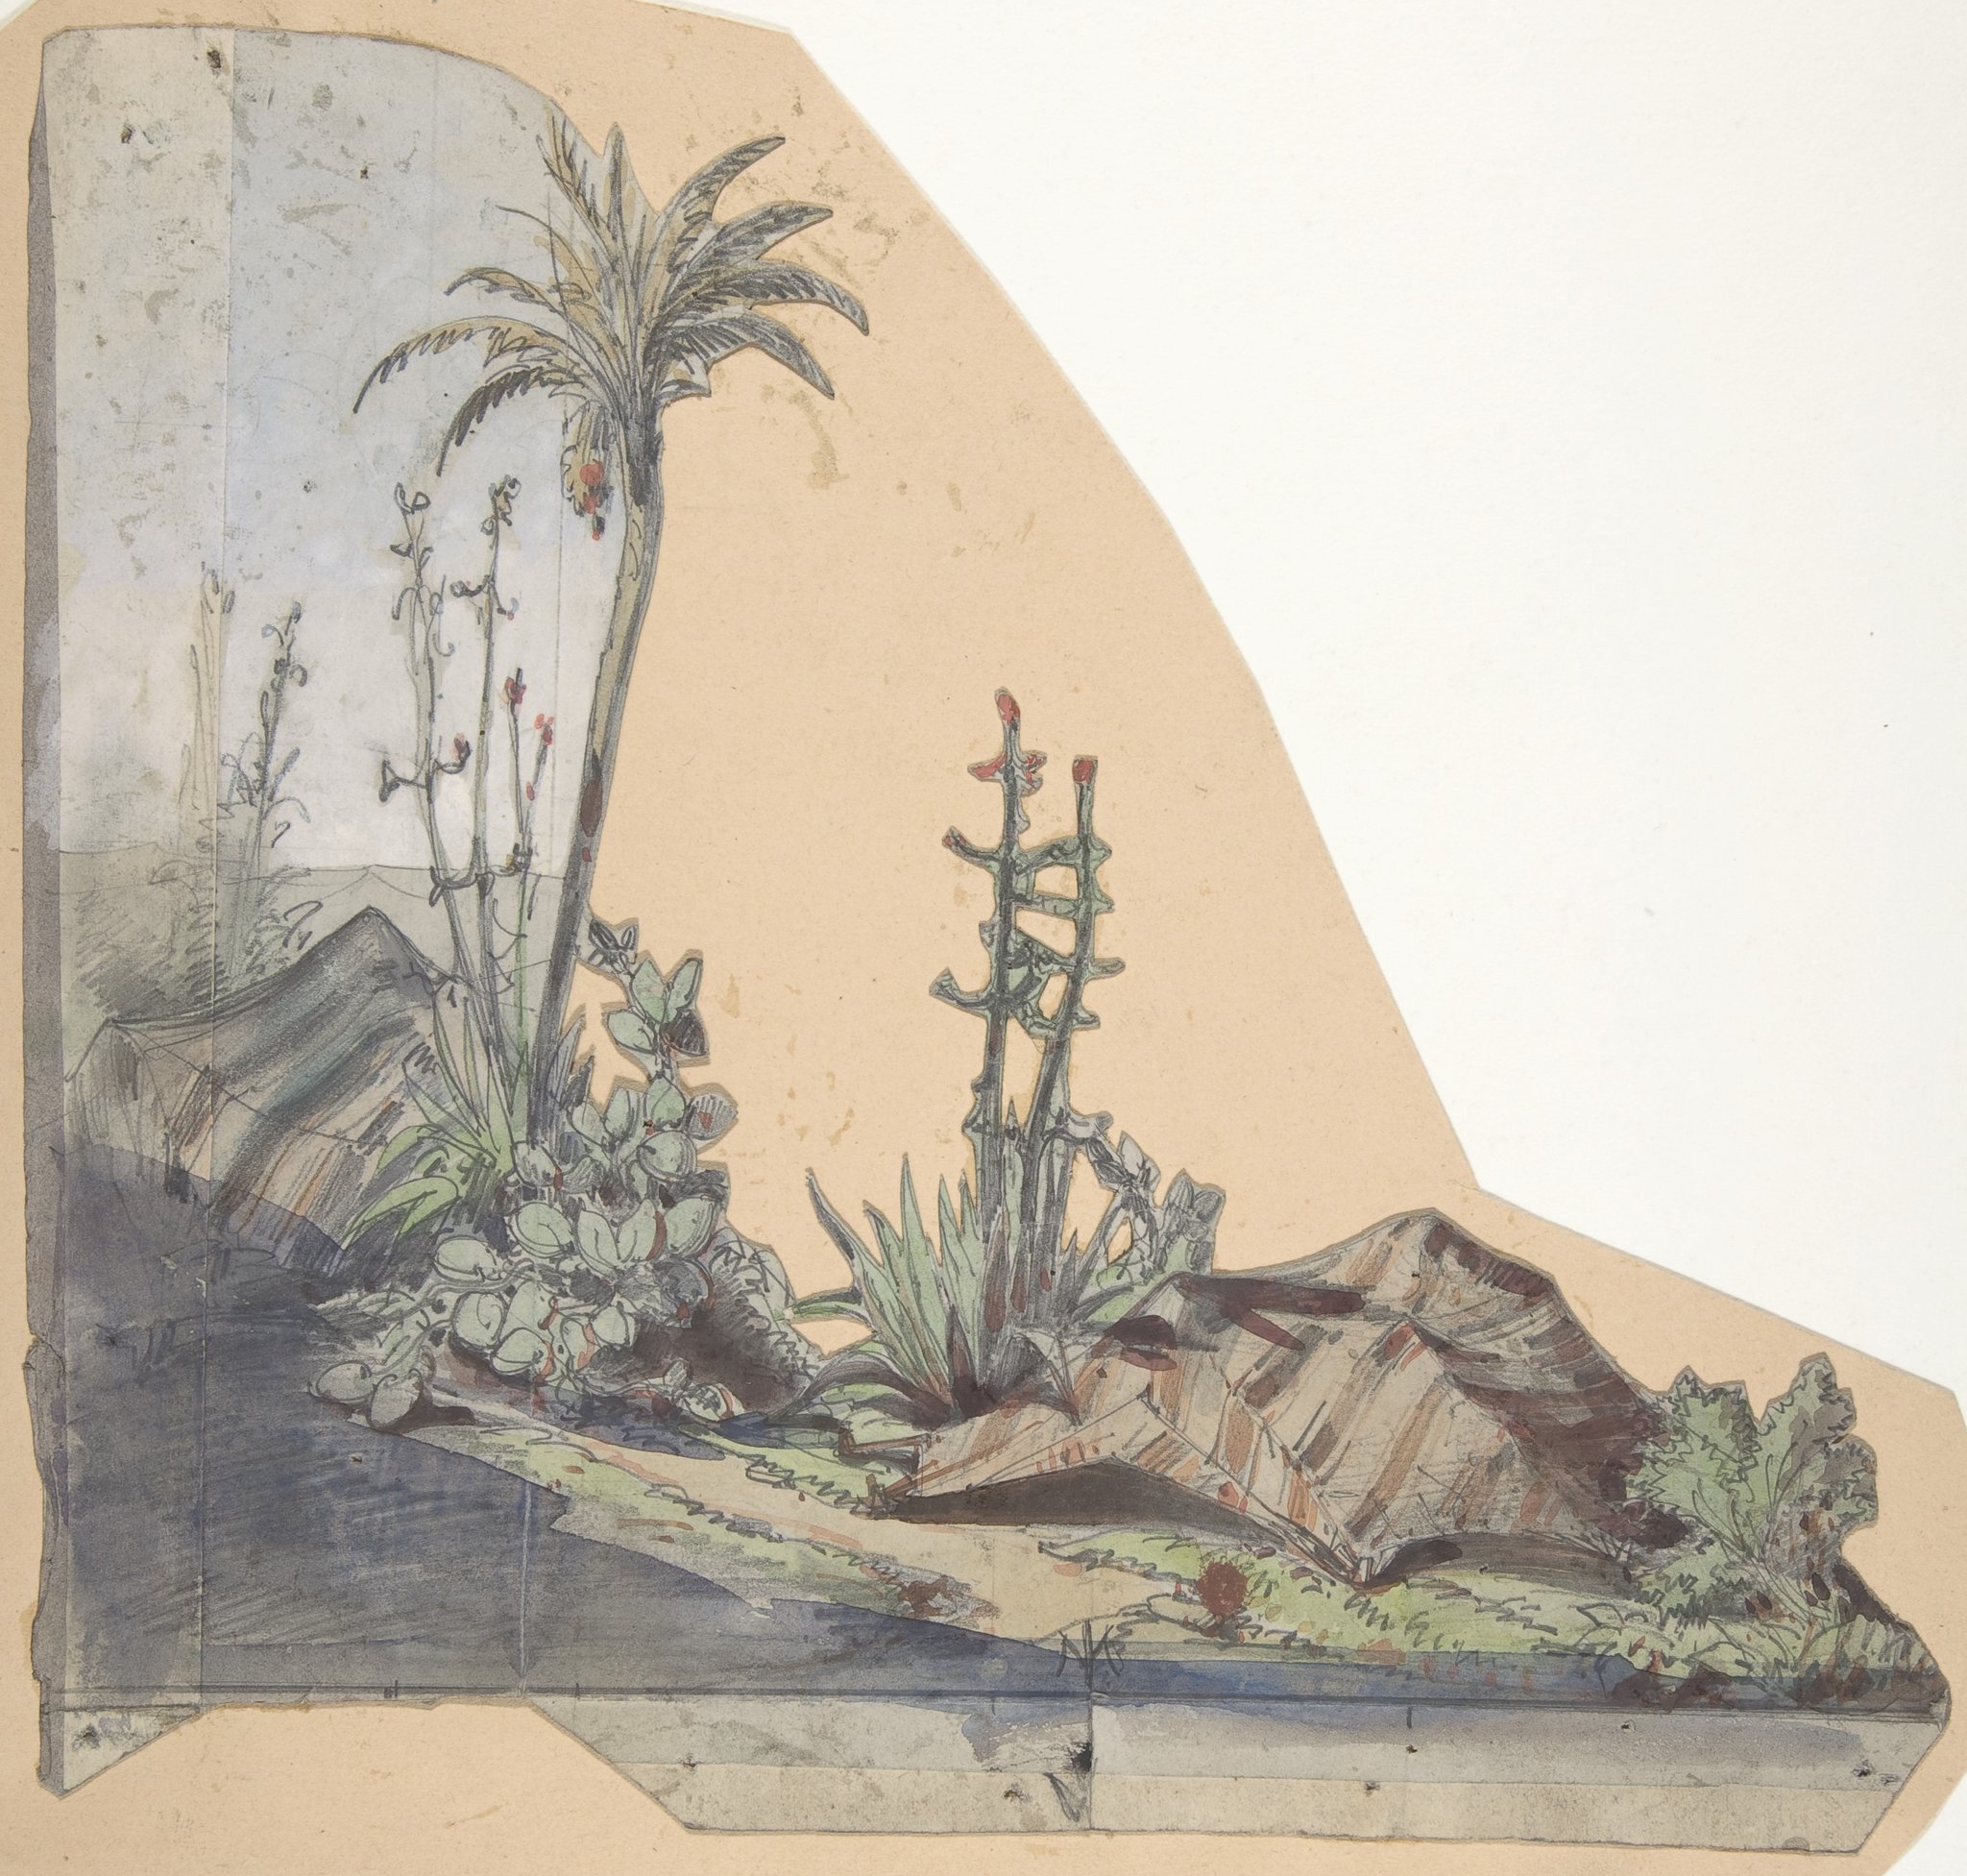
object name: drawing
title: Design for a Stage Set at the Opéra, Paris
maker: eugène cicéri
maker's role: artist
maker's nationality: french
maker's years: 1813-1890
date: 1830-1890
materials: graphite, watercolor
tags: trees,stage design